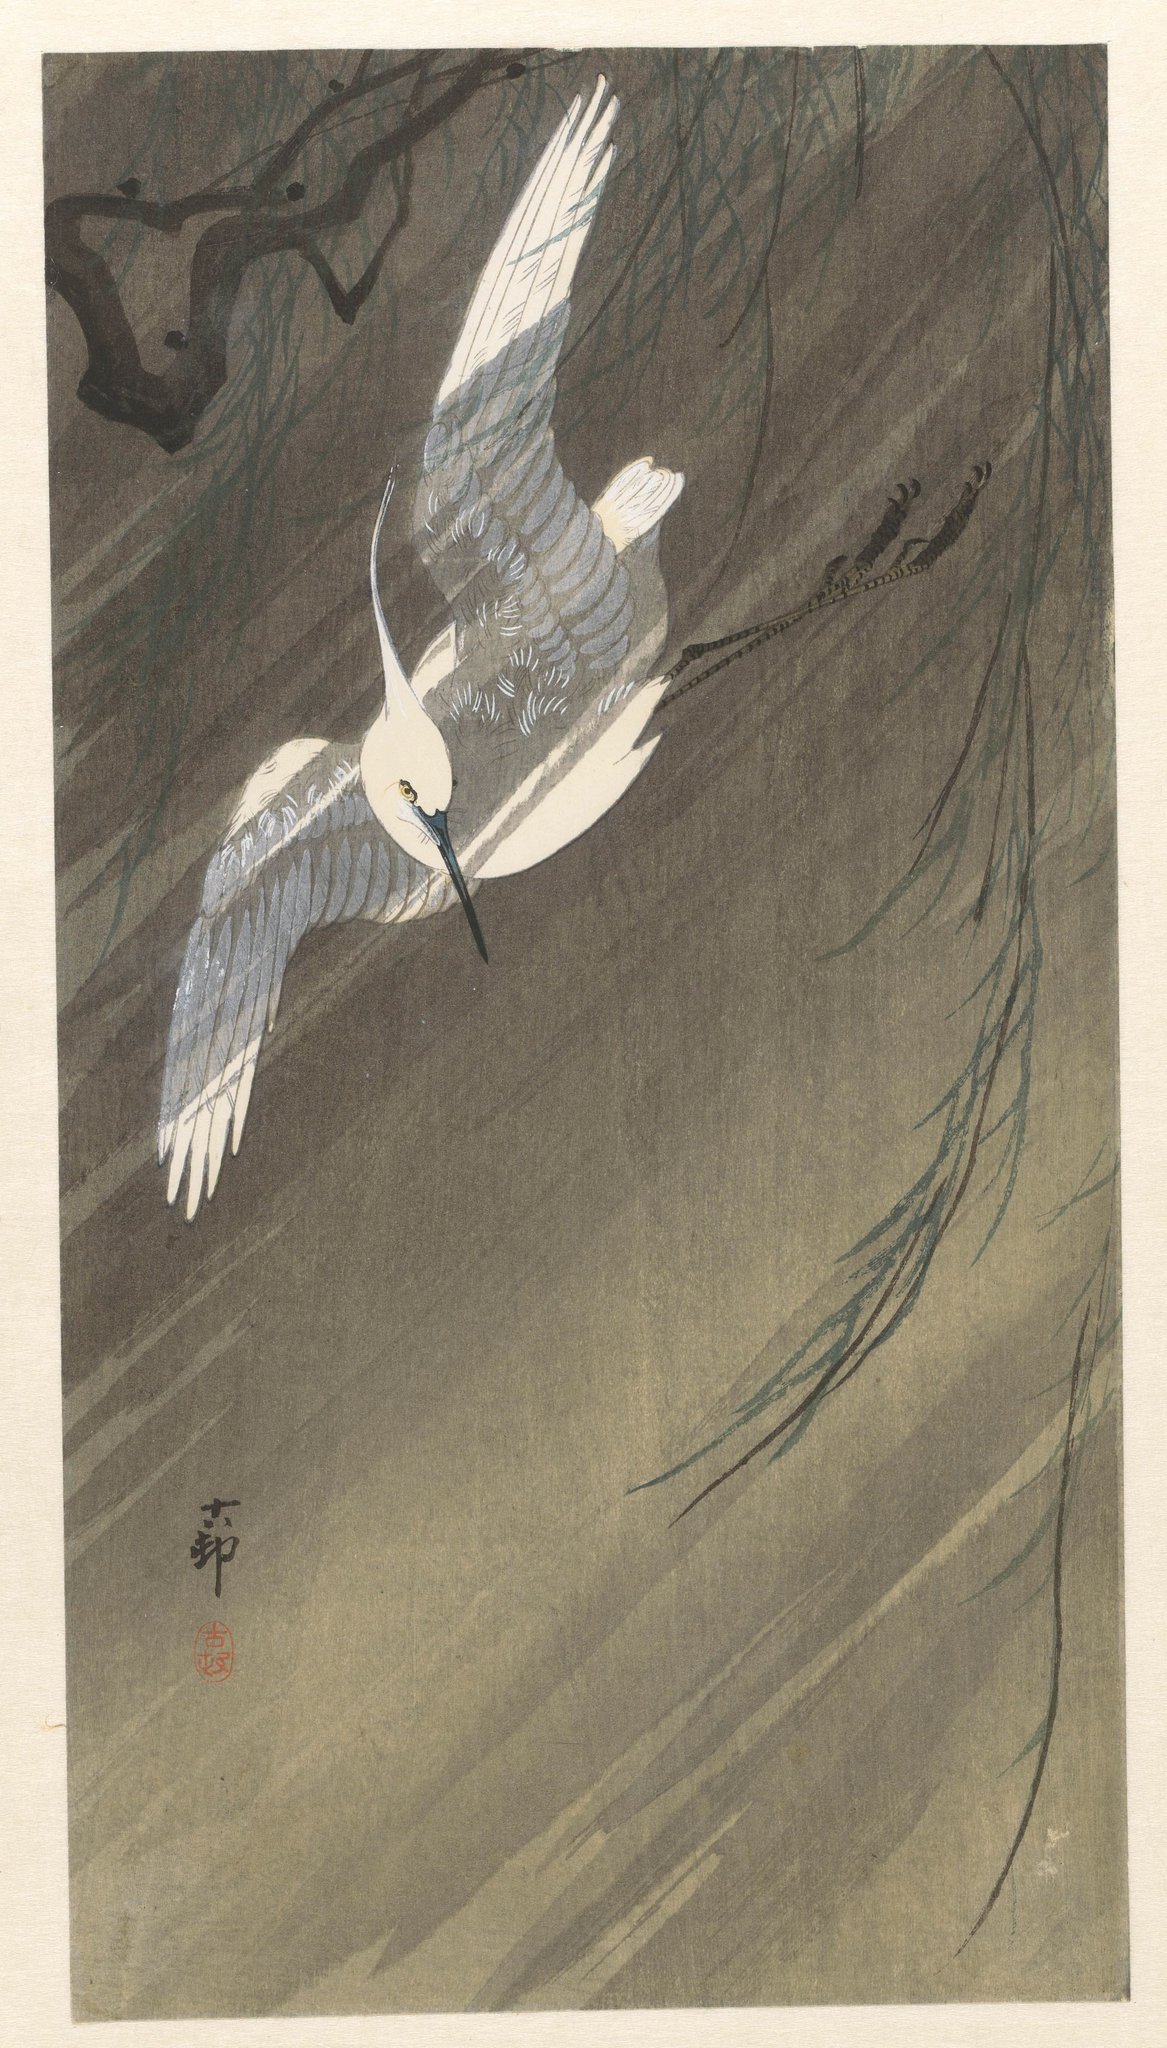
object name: print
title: Zilverreiger in storm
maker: ohara koson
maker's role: print maker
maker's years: 1877-1945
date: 1900-1936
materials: paper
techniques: woodcut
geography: japan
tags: shore-birds and wading-birds: heron, winds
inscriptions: collector's mark: Lugt 2228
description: Zilverreiger in vlucht, naar beneden, bij wilgentakken in storm